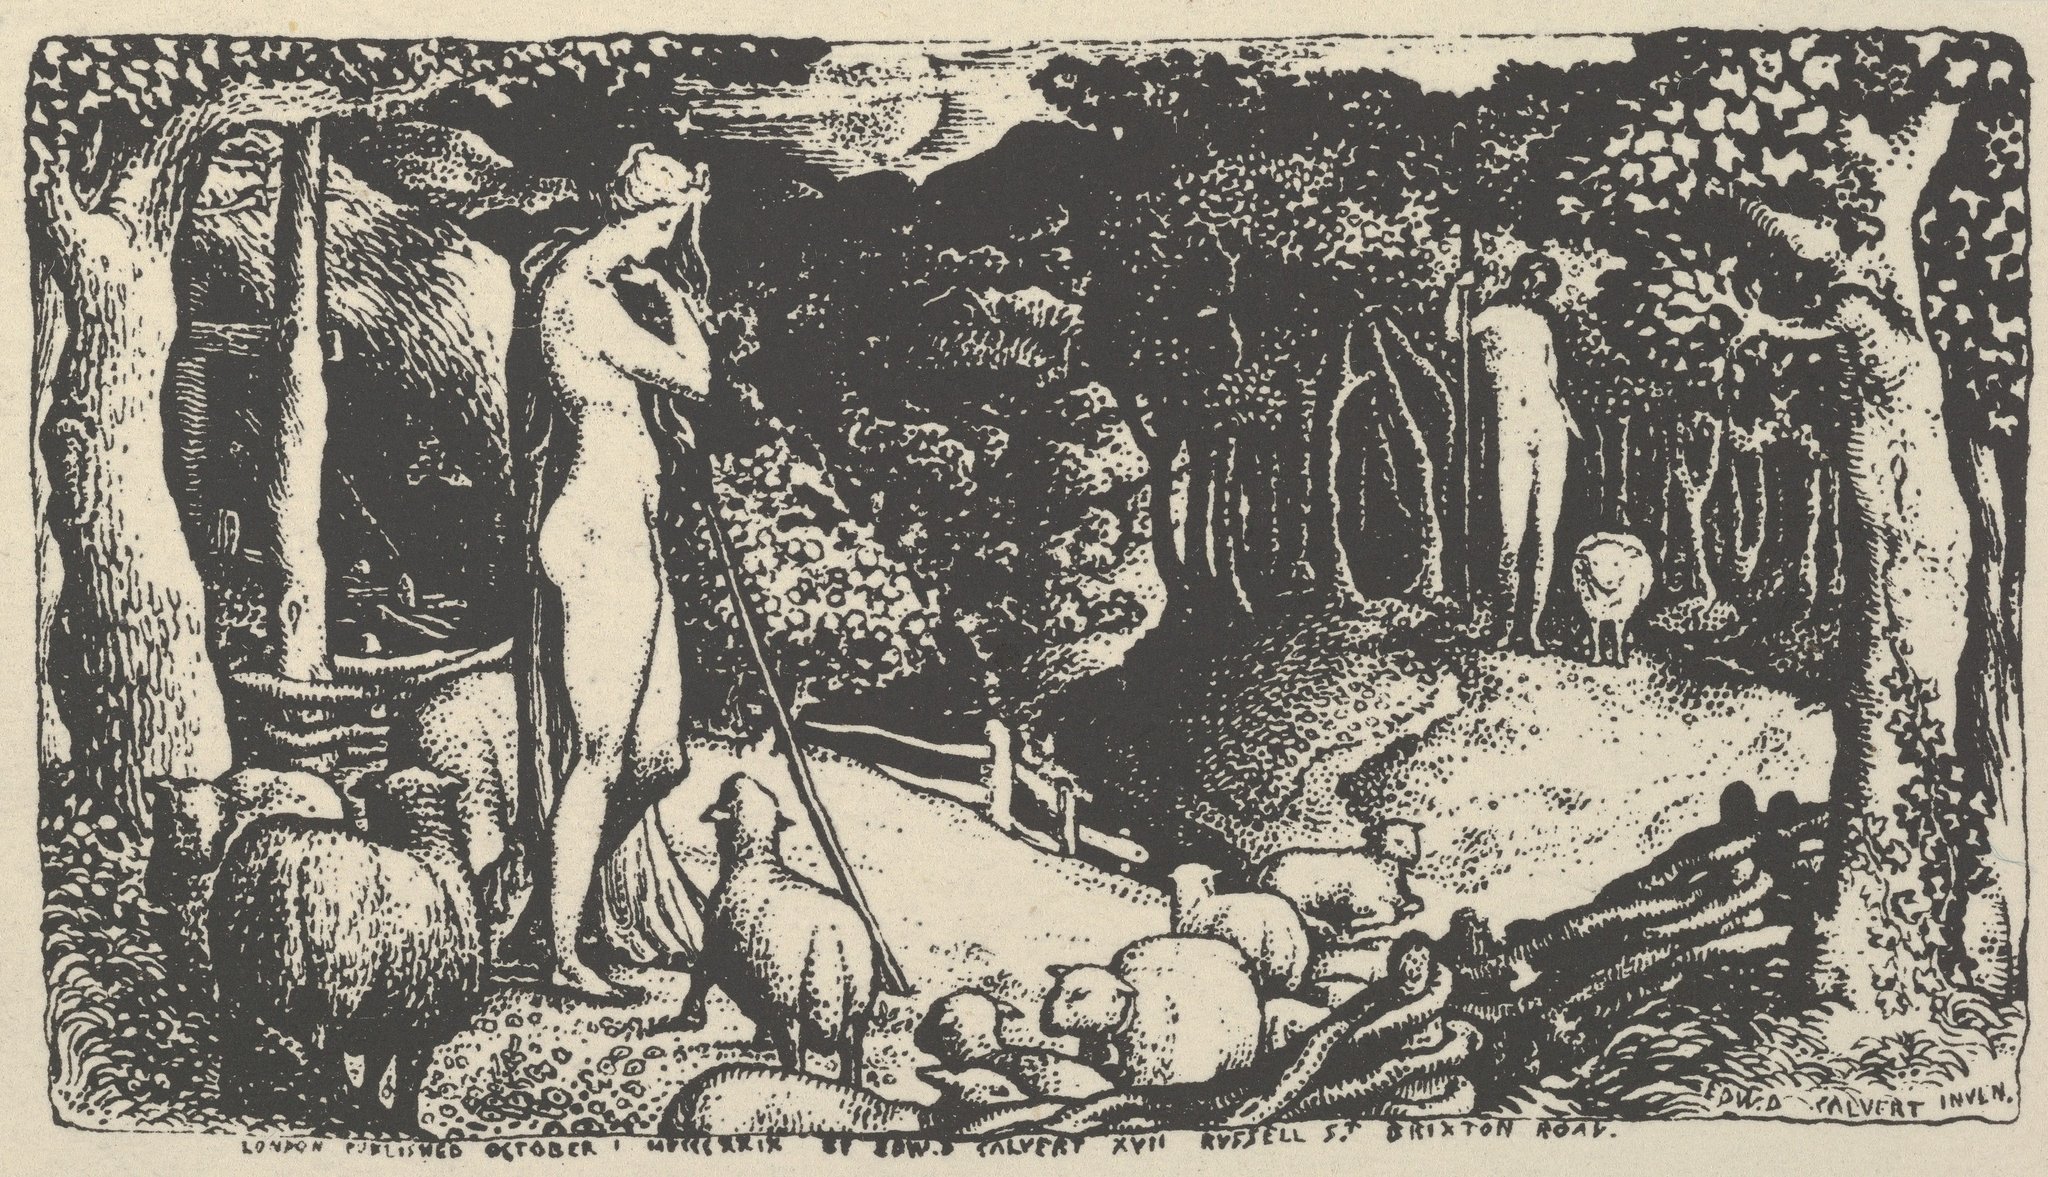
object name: print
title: Ideal Pastoral Life, reproduced for Calver's "Memoir"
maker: edward calvert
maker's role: artist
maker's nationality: british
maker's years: 1799-1883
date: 1904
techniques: lithograph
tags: male nudes,female nudes,sheep,trees